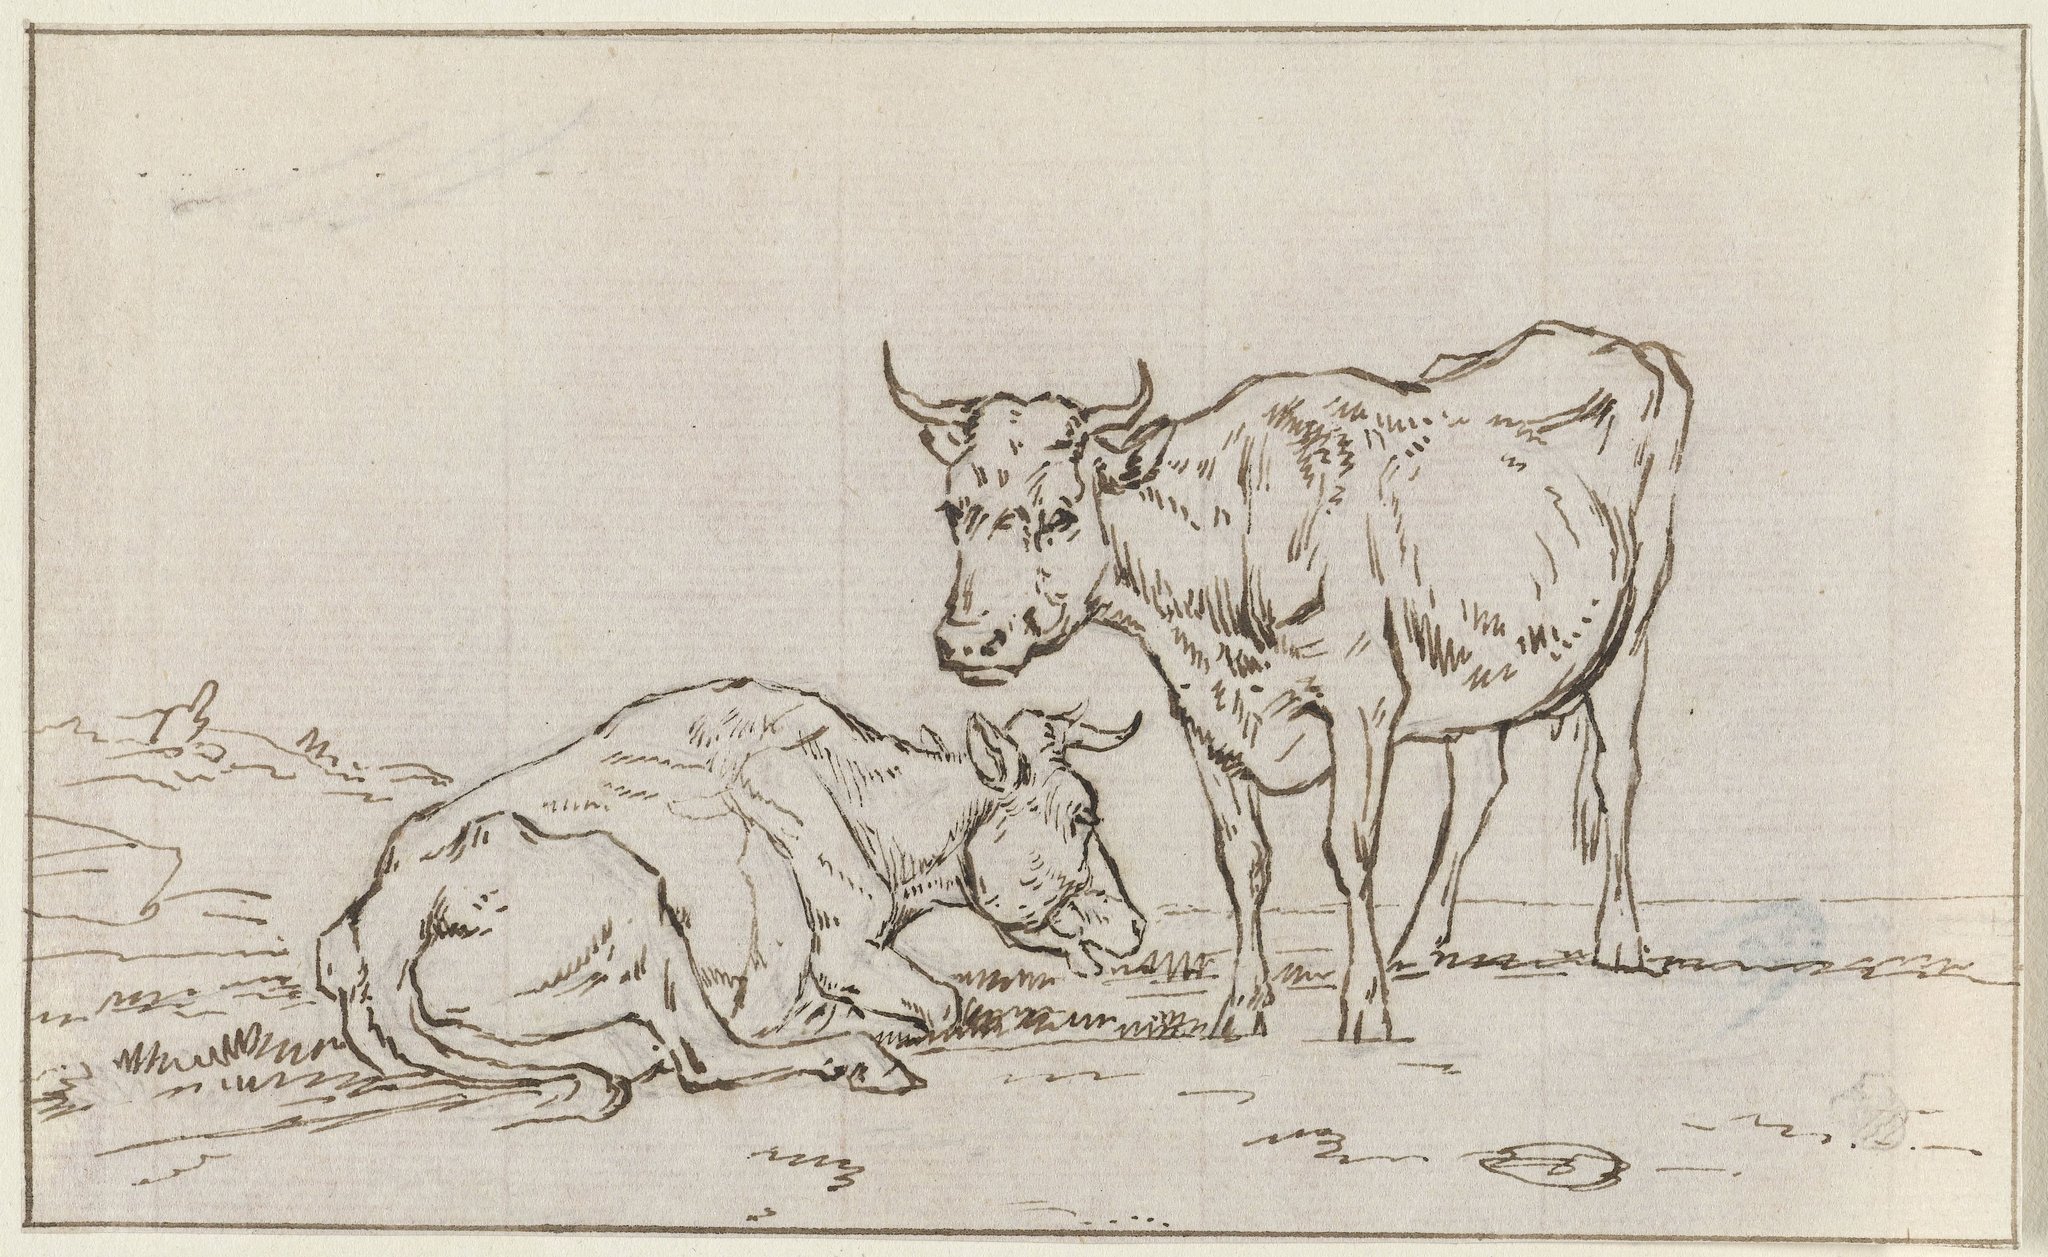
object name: print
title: Koeien in een landschap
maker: jan kobell (ii)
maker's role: draughtsman, painter, print maker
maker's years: 1778-1814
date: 1788-1814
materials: paper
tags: cow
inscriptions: collector's mark: Lugt 2228, collector's mark: Lugt 2760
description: Een liggende en een staande koe bij een vervallen hek. Op de achtergrond staat een derde koe te grazen en zijn de contouren van een kerktoren te zien